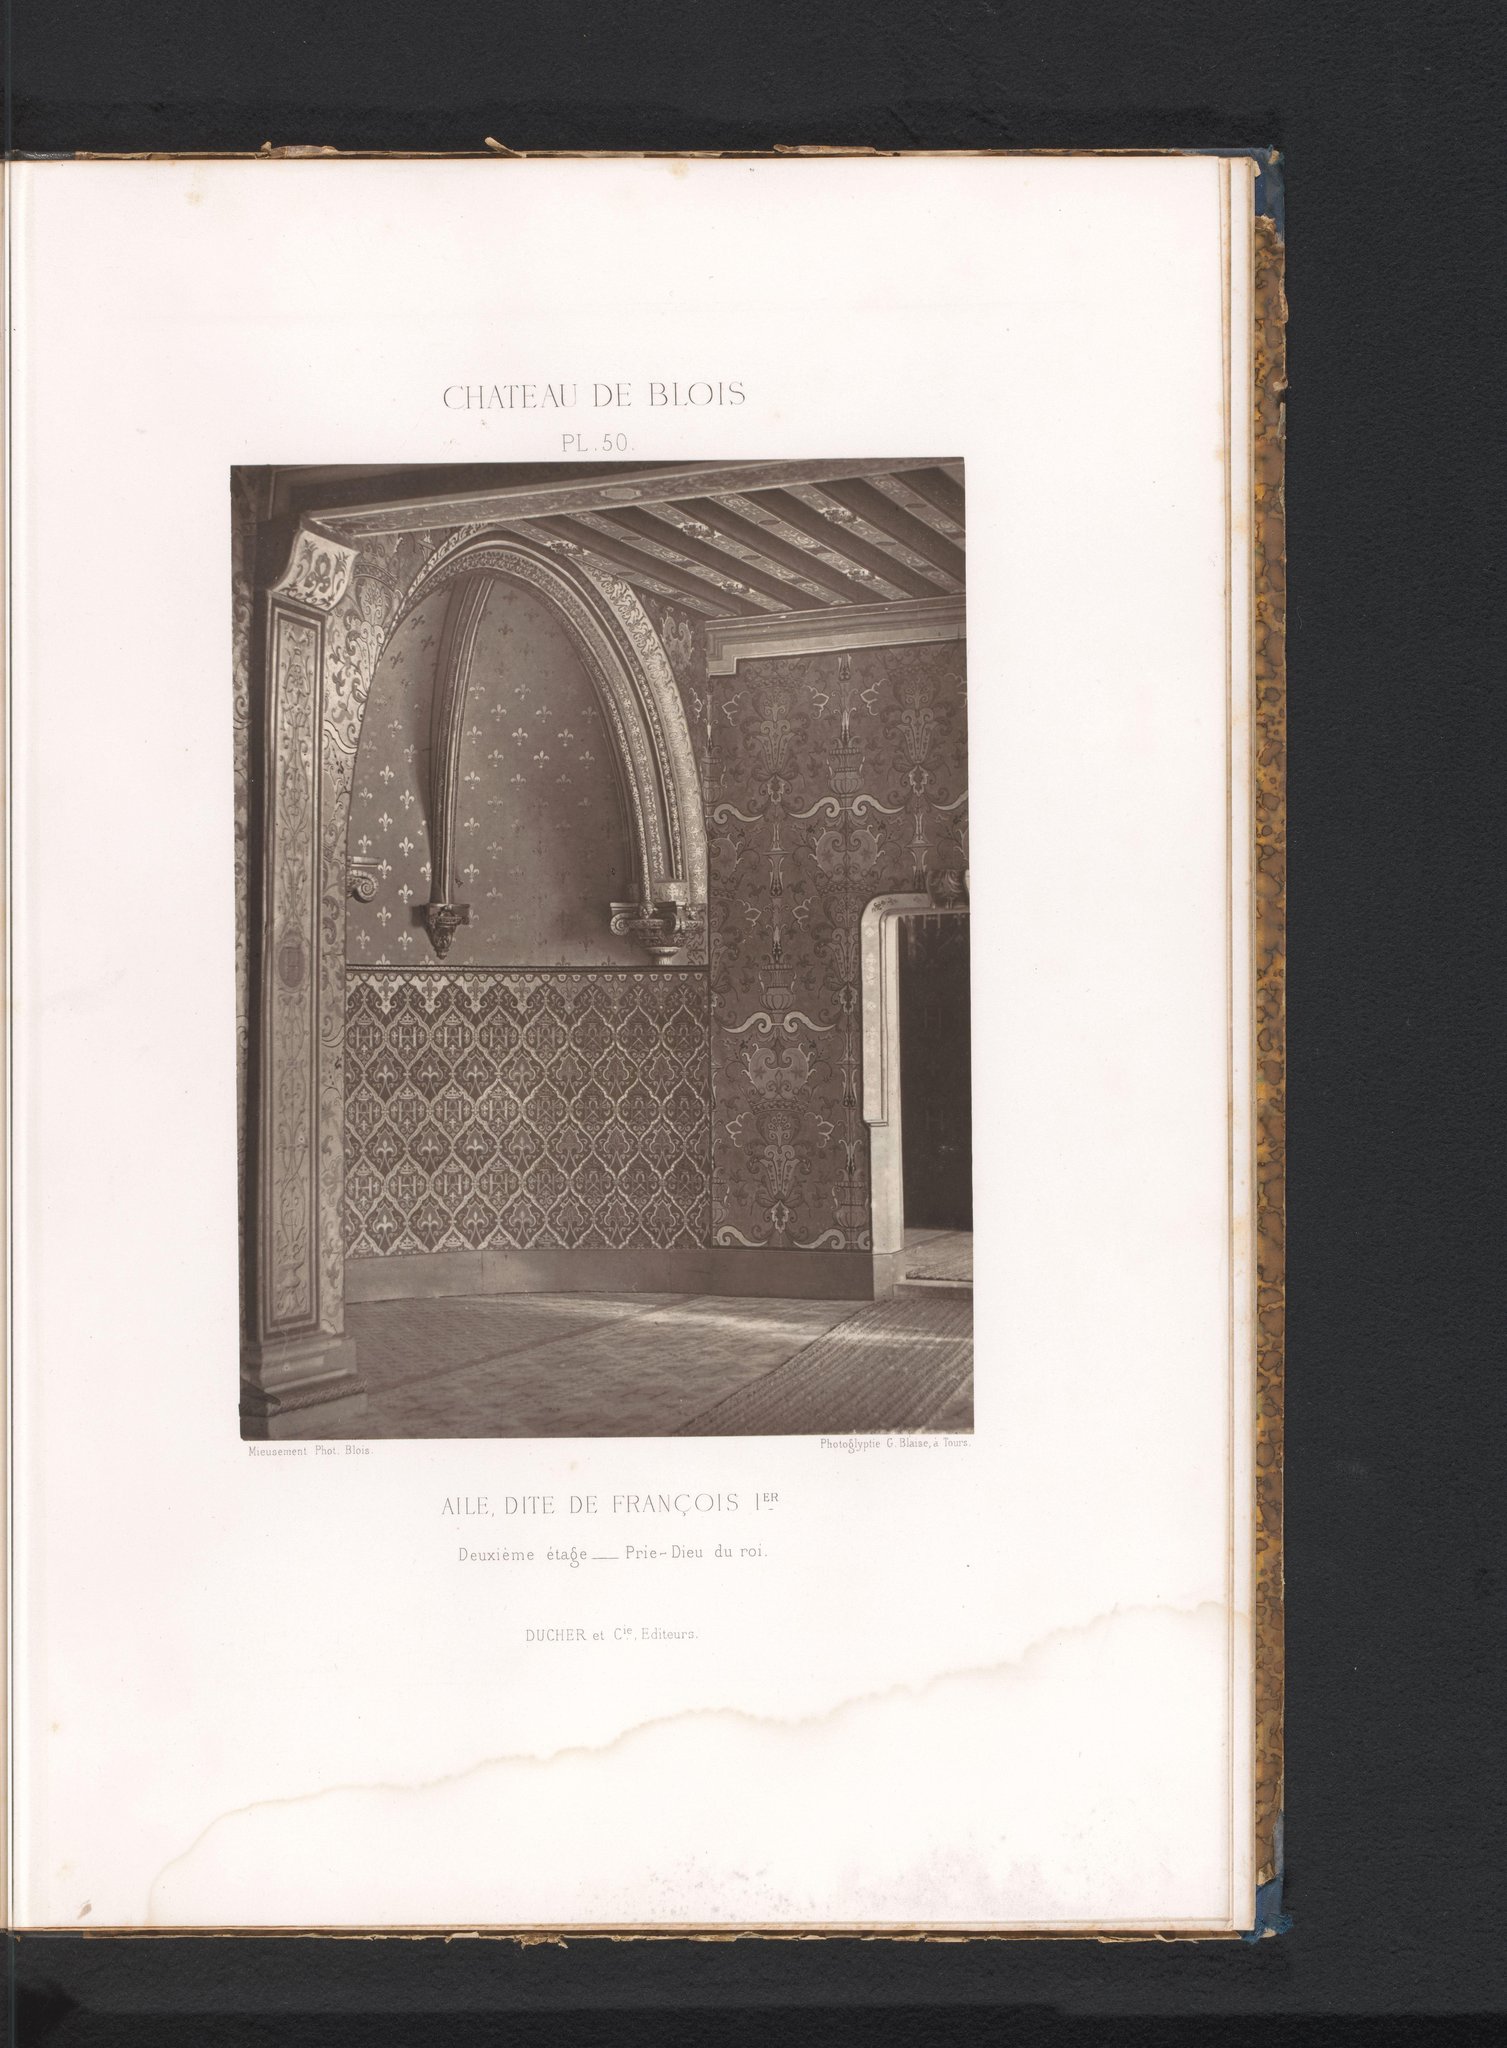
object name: photomechanical print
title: Gezicht op een deel van de tweede etage van de Frans I vleugel van het Kasteel van Blois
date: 1870-1875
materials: paper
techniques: woodburytype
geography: blois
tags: castle, other rooms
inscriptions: number: ‘PL. 50.’